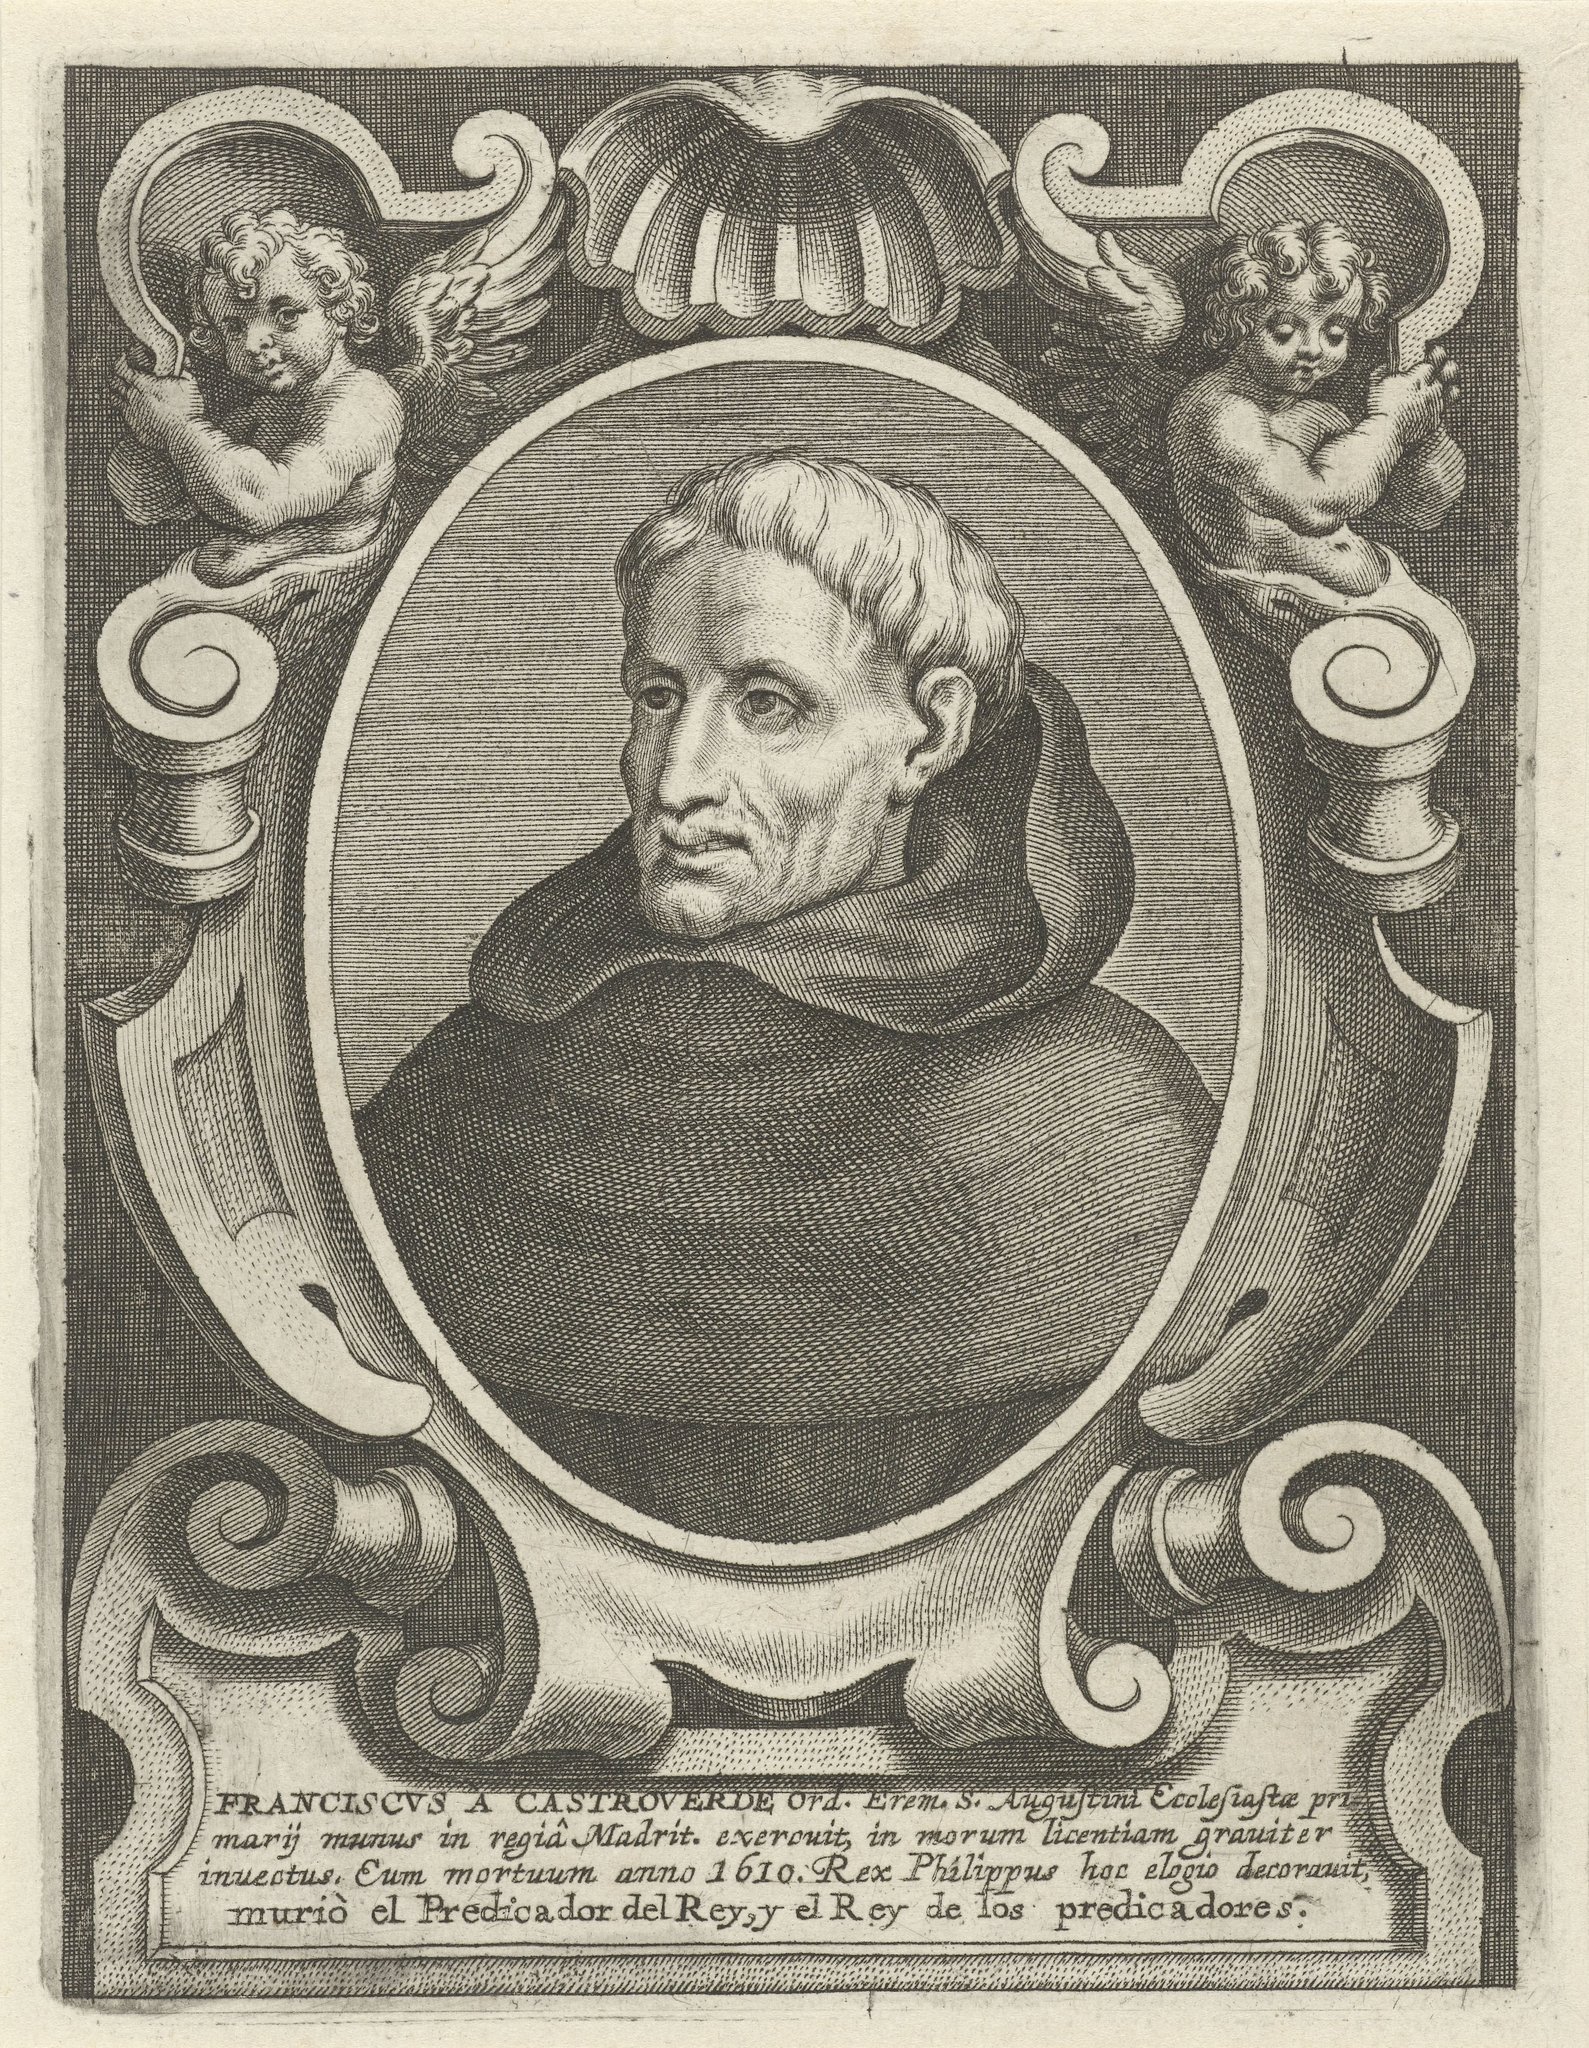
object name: book illustration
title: Portret van de Augustijn Franciscus de Castro Verde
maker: cornelis galle (i)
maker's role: print maker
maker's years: 1576-1650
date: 1636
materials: paper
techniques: engraving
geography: southern netherlands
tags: monastic orders, monastic life ~ roman catholic church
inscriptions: collector's mark: Lugt 2228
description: Boekillustratie voor: C. Curtius, Virorum illustrium ex ordine Eremitarum D. Augustini elogia , Antwerpen: J. Cnobbaert, 1636.